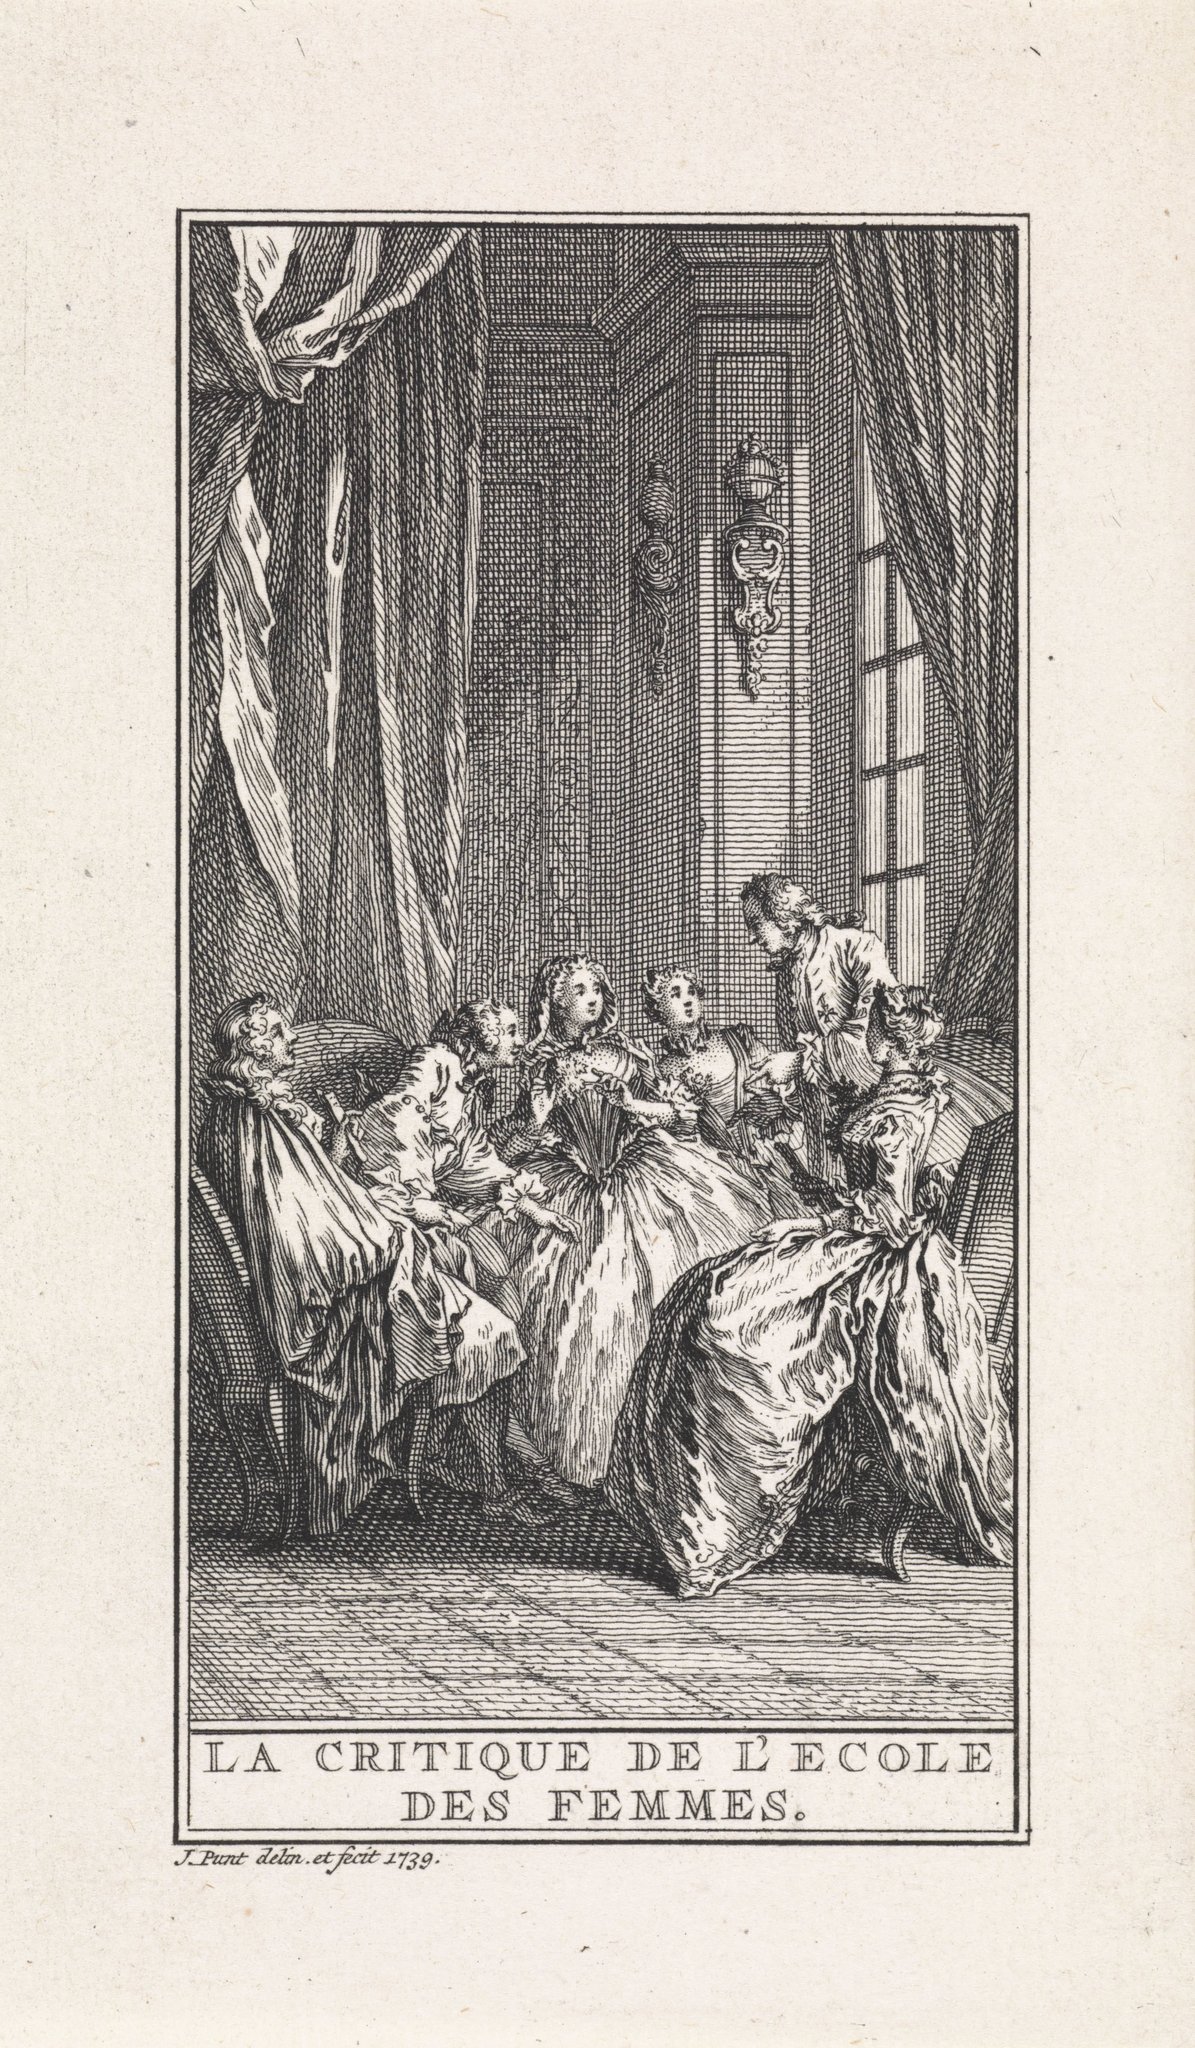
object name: print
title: La Critique de L'Ecole des Femmes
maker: jan punt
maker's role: draughtsman, print maker, publisher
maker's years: 1711-1779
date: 1739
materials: paper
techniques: engraving, etching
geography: amsterdam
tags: fashionable woman, 'belle'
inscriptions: collector's mark: Lugt 2228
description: Een groep vrouwen zit op stoelen in een kring in een vertrek. Een man spreekt hen toe. Scène uit het toneelstuk La Critique de l'école des femmes, van Molière.